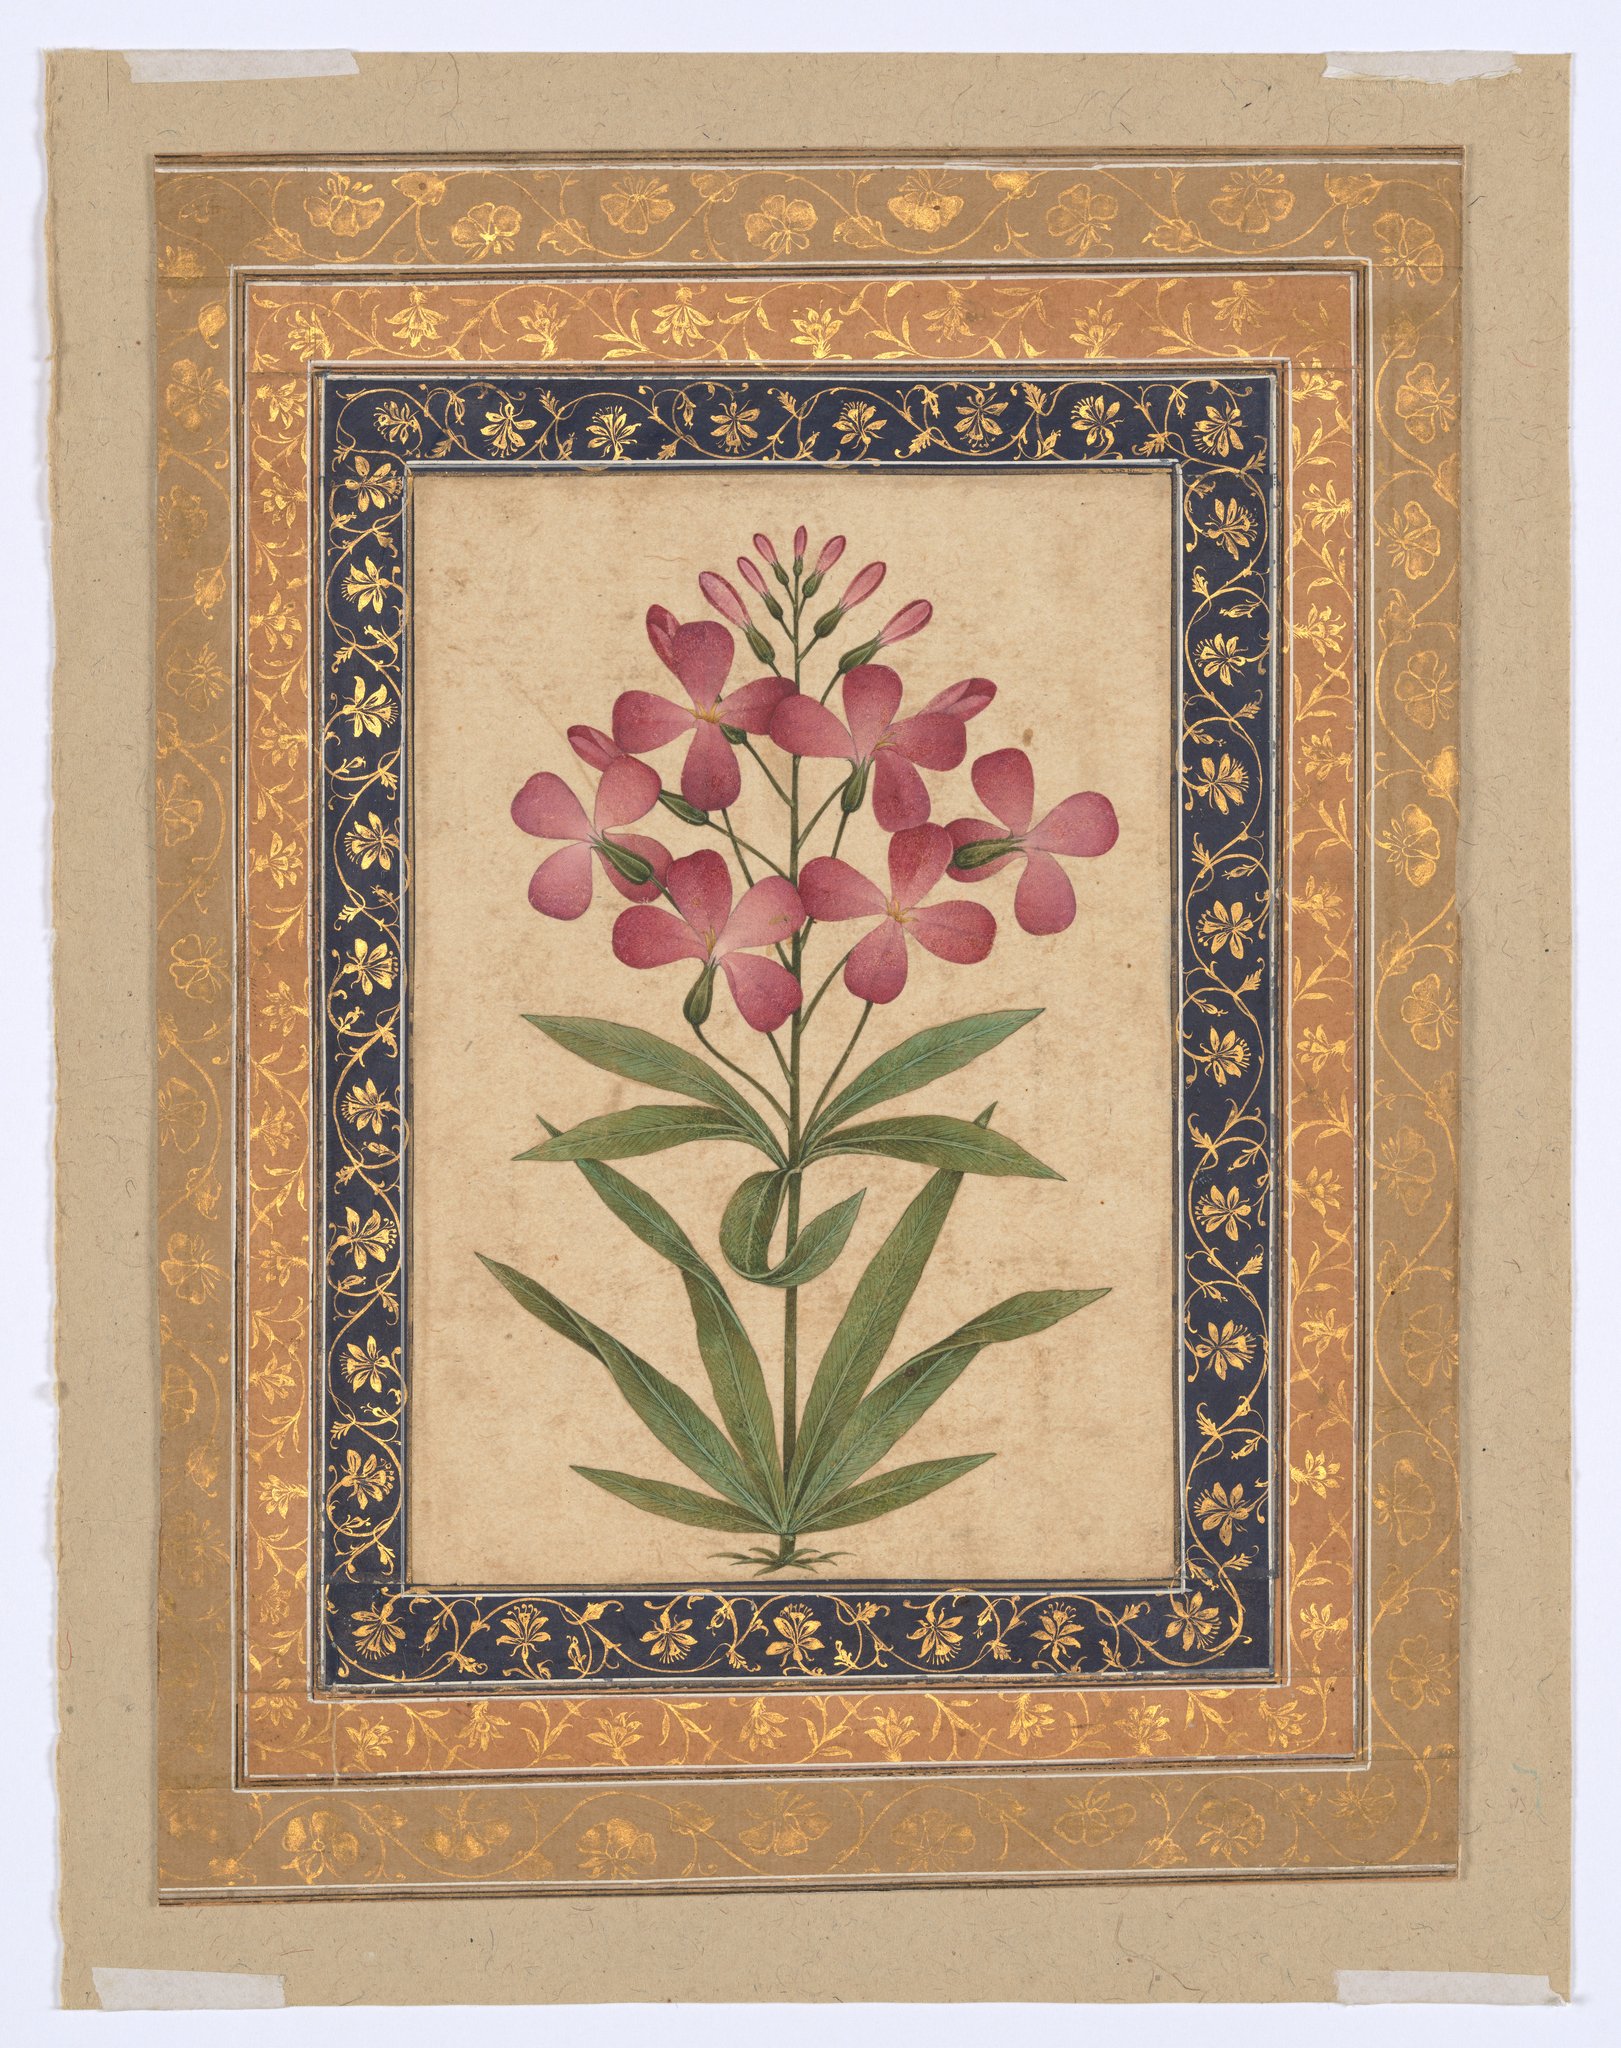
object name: illustrated single work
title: Botanical Painting: Geranium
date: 1630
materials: paper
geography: india